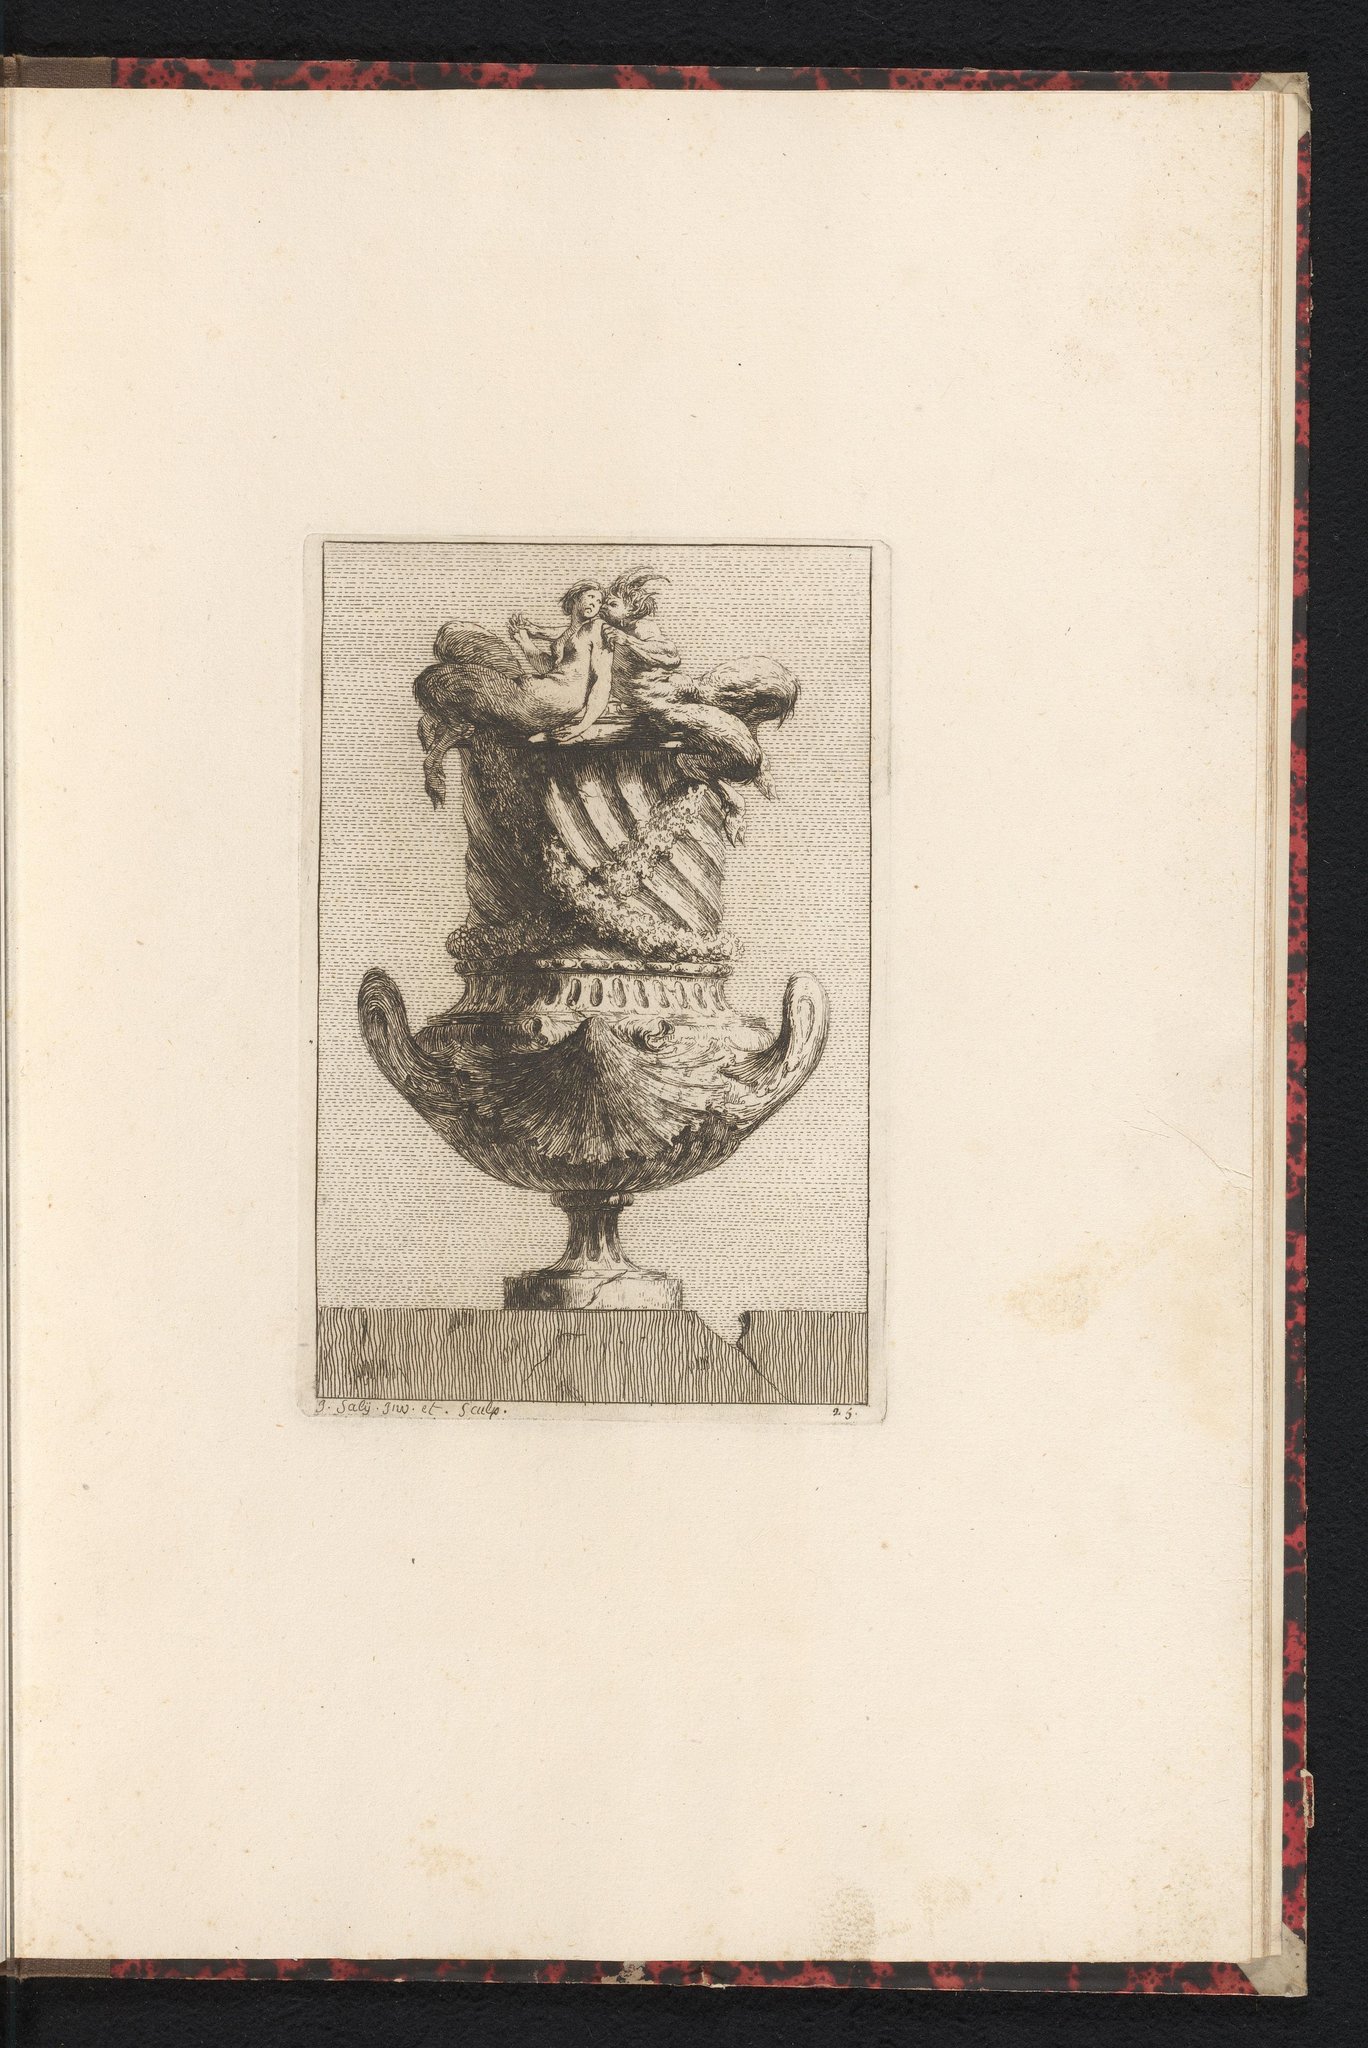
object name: ornament print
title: Vasa a se inventa atq. studii causa delin. et incisa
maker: jacques francois joseph saly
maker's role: print maker, sculptor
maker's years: 1717-1776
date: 1746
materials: paper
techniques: etching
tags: satyr(s) (in general), garden vase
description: Deze prent maakt deel uit van een album.